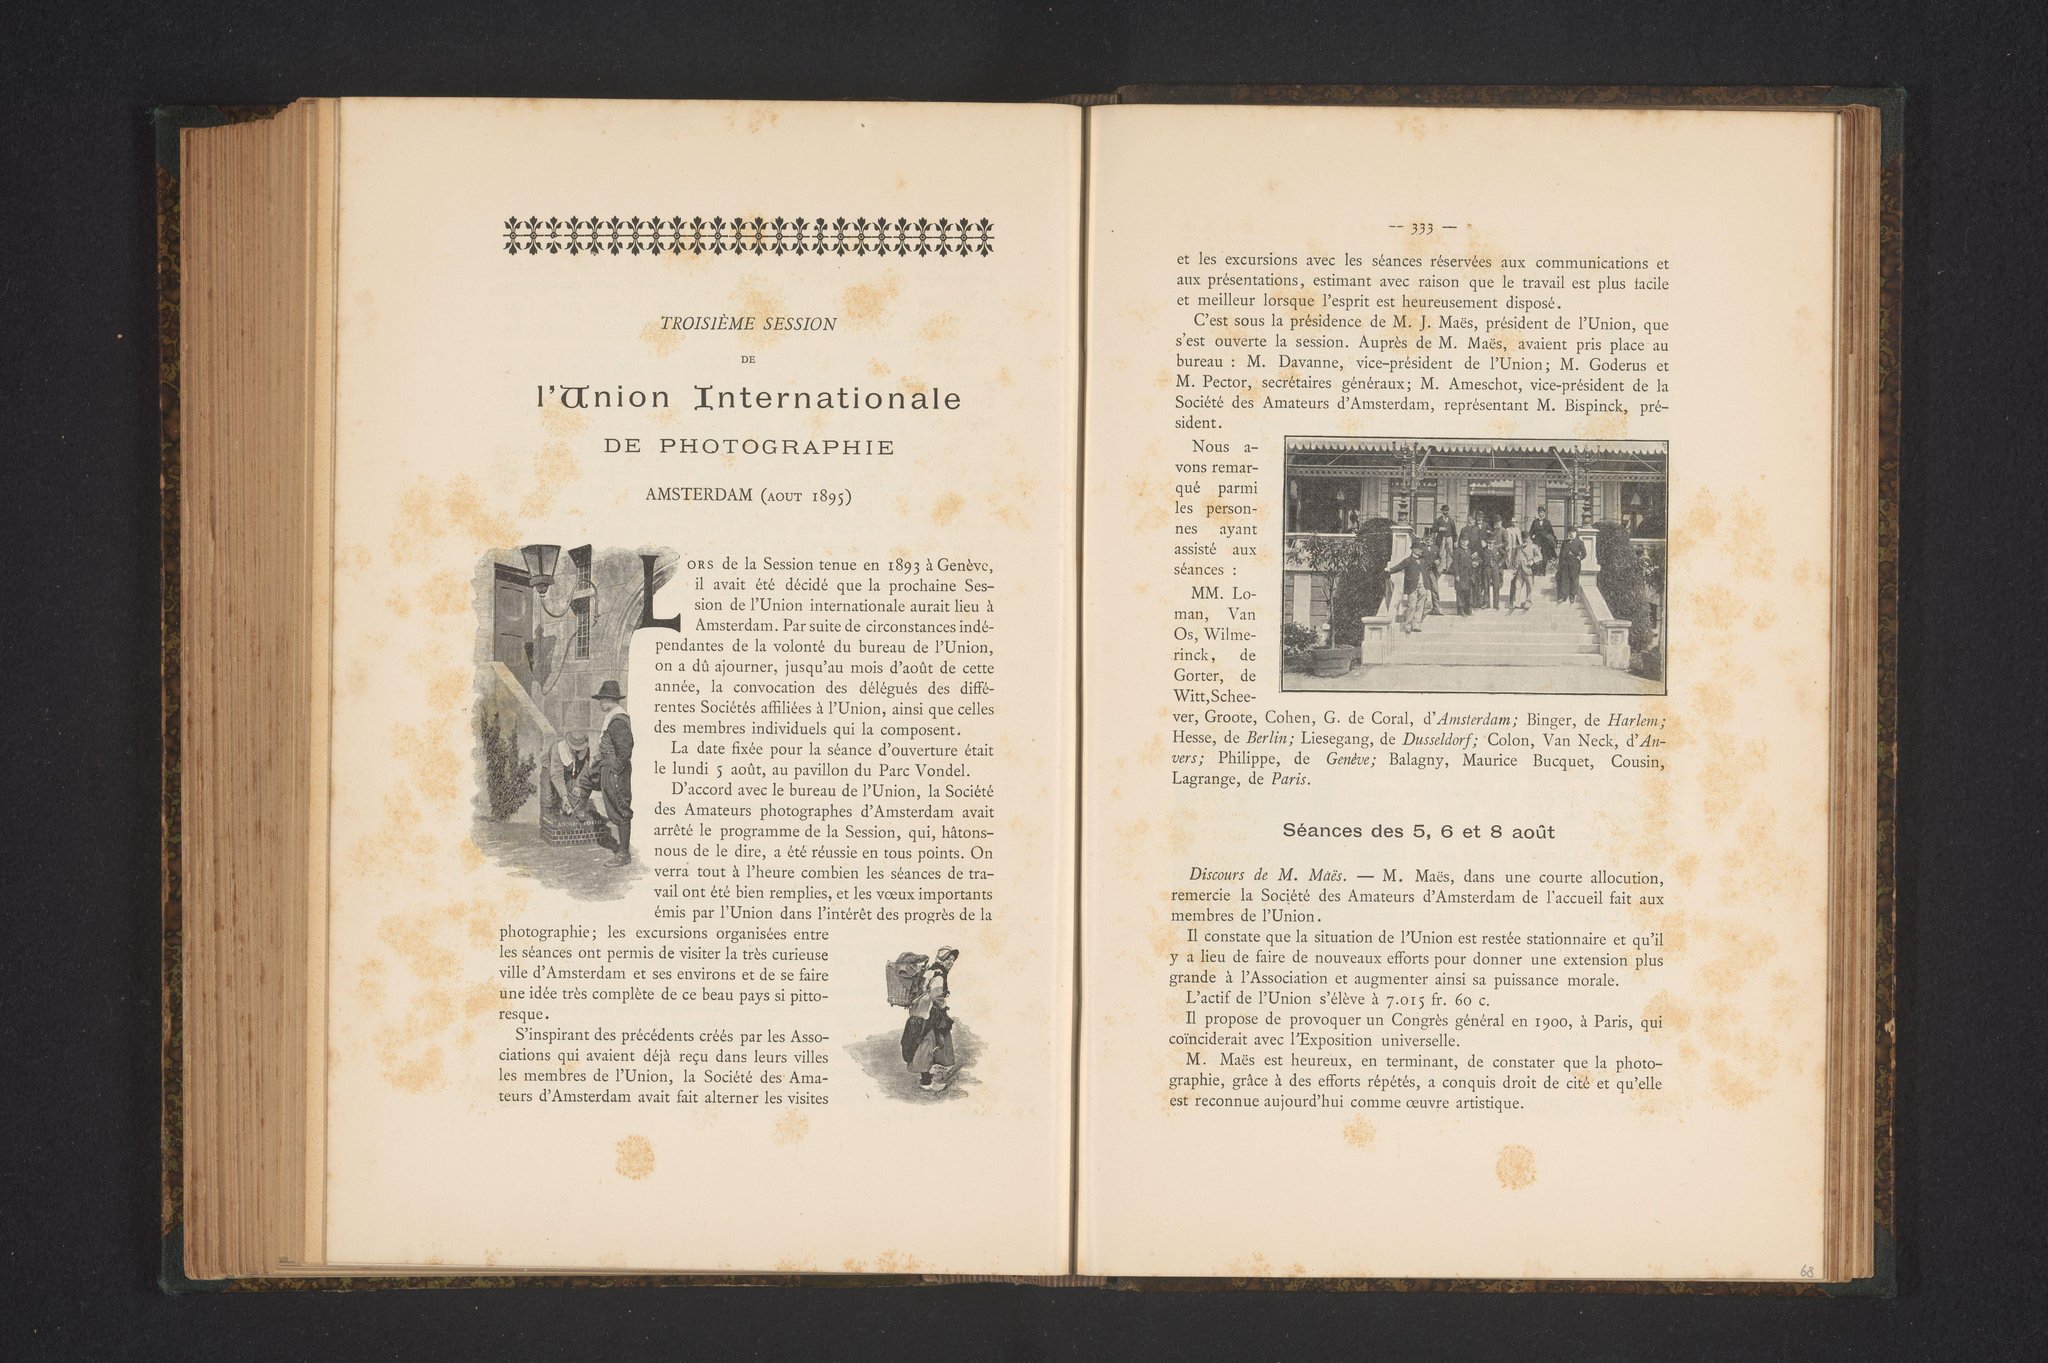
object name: photomechanical print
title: Man laat zijn schoenen poetsen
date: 1890-1895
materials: paper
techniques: autotype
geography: amsterdam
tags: cleaning of material, shoes, sandals, amsterdam